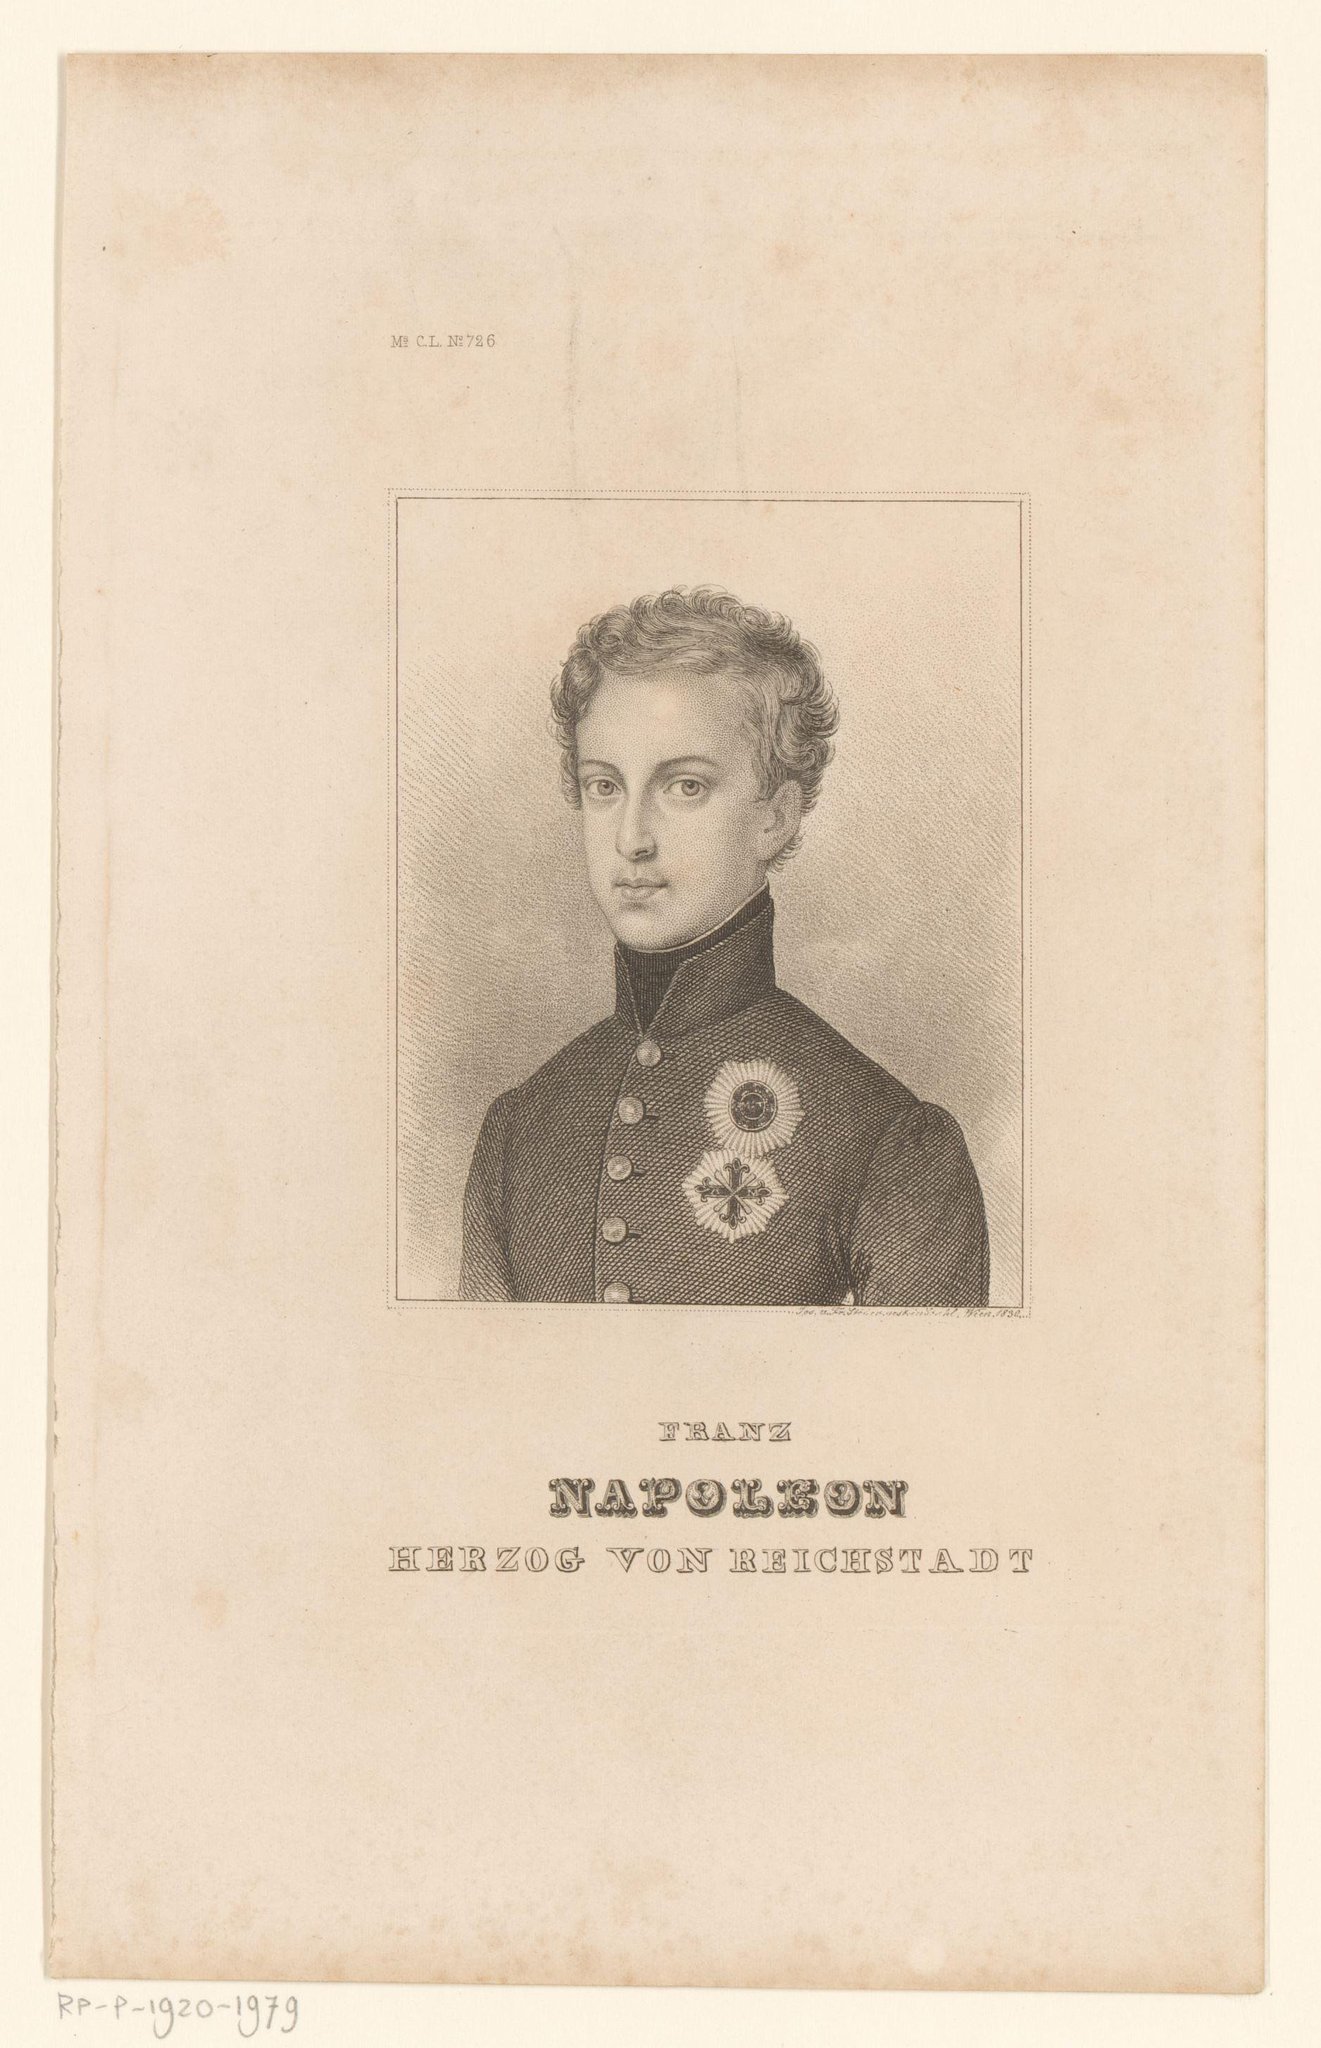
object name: book illustration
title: Portret van Napoleon Frans Karel Jozef Bonaparte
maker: franz stöber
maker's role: painter, print maker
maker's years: 1760-1834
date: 1830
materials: paper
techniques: engraving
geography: vienna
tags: paris, historical persons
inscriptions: collector's mark: Lugt 2228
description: Prent afkomstig uit: Conversations-Lexikon für die gebildeten Stände, voor het eerst uitgegeven tussen 1840-1855.